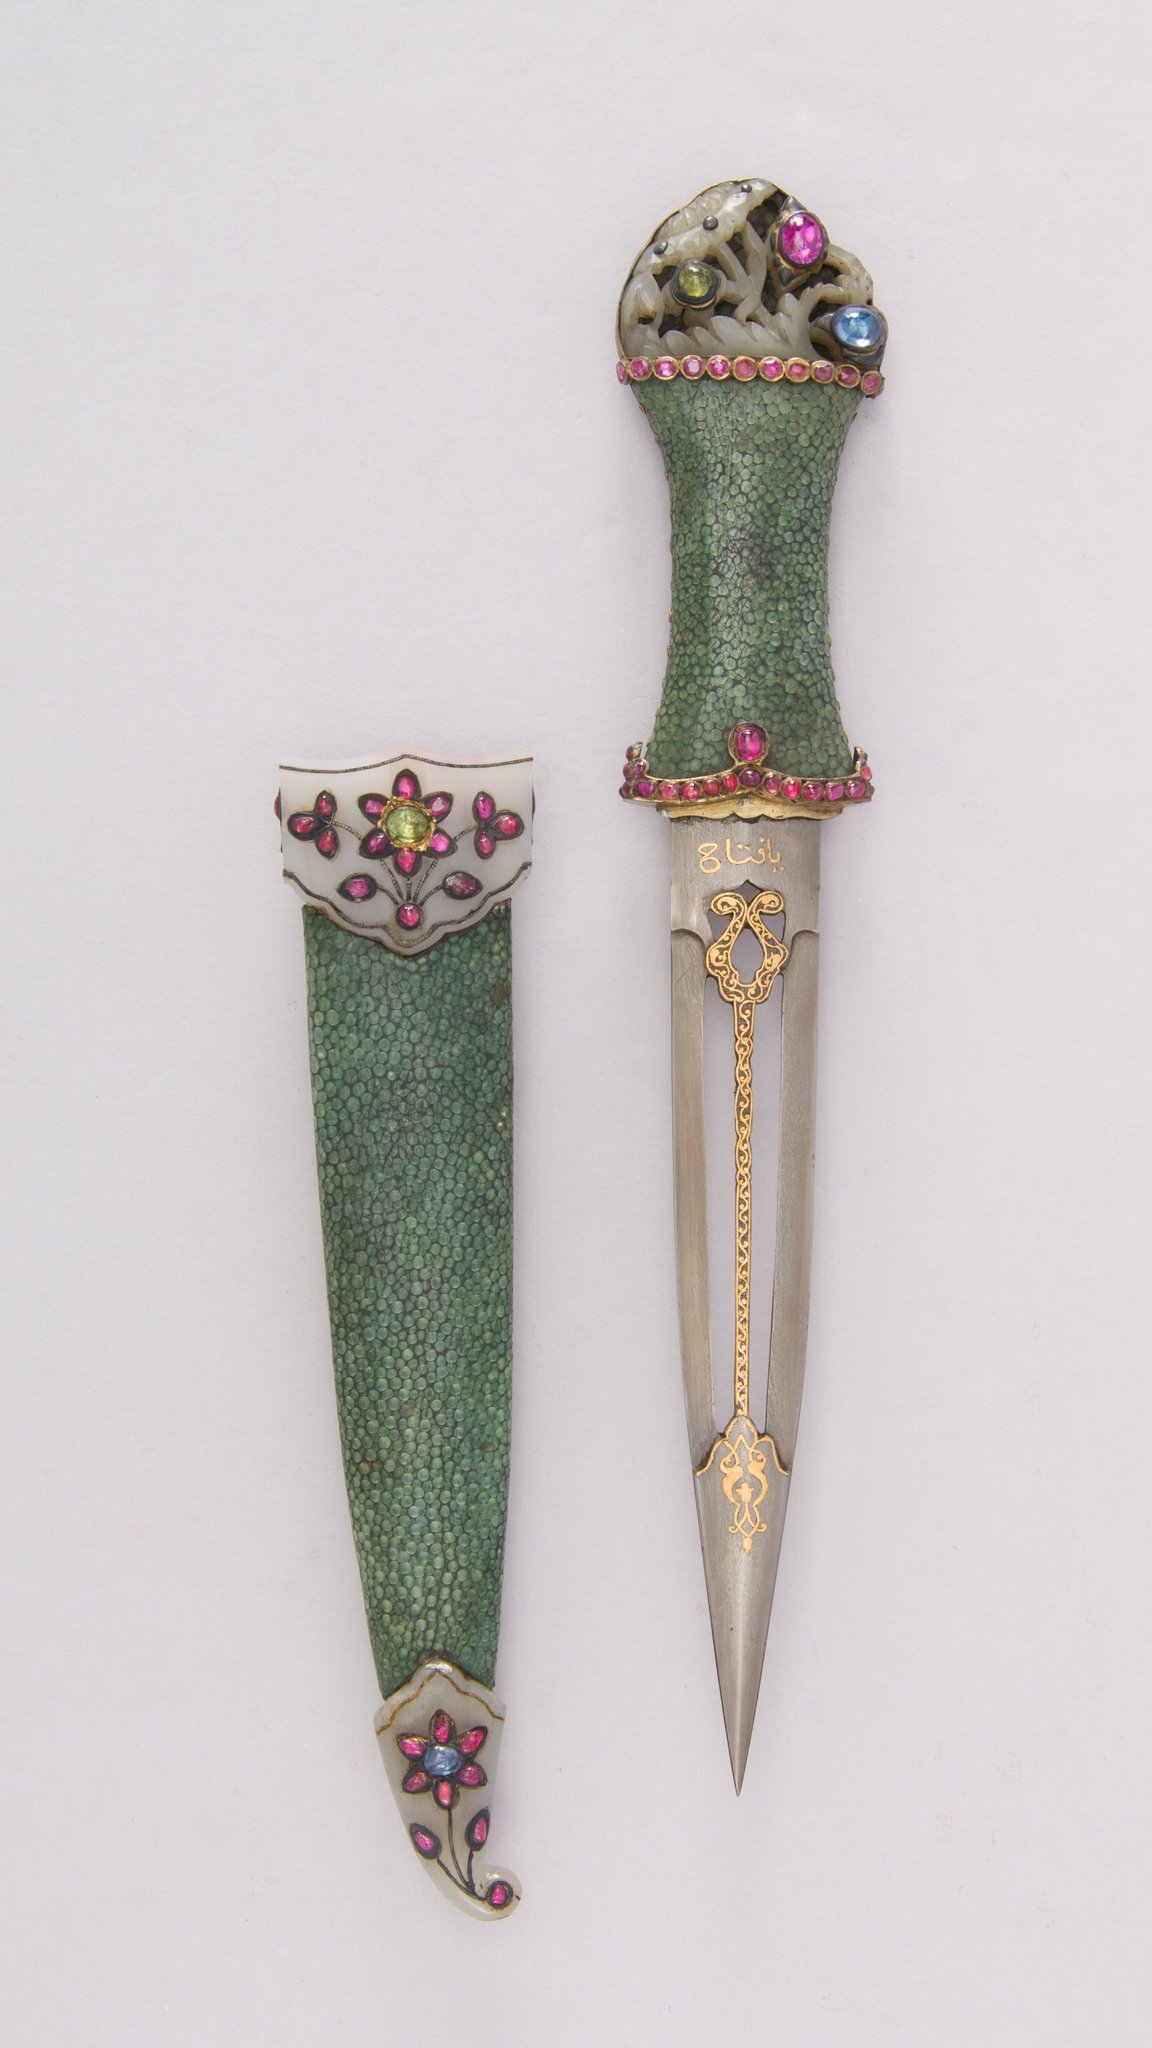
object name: dagger with sheath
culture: indian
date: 1701-1800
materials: gemstone, gold, jade, silver, skin, steel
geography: india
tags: flowers